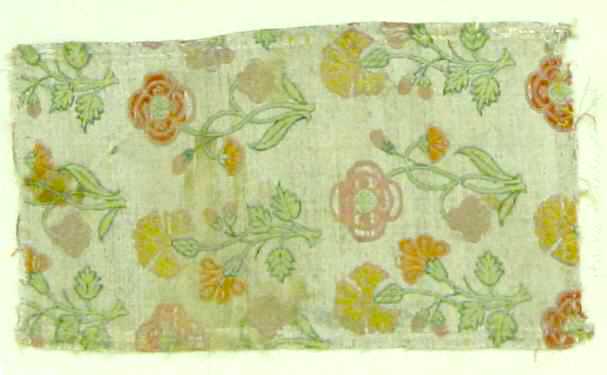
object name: textile fragment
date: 1601-1700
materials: metal thread, silk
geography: iran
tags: flowers